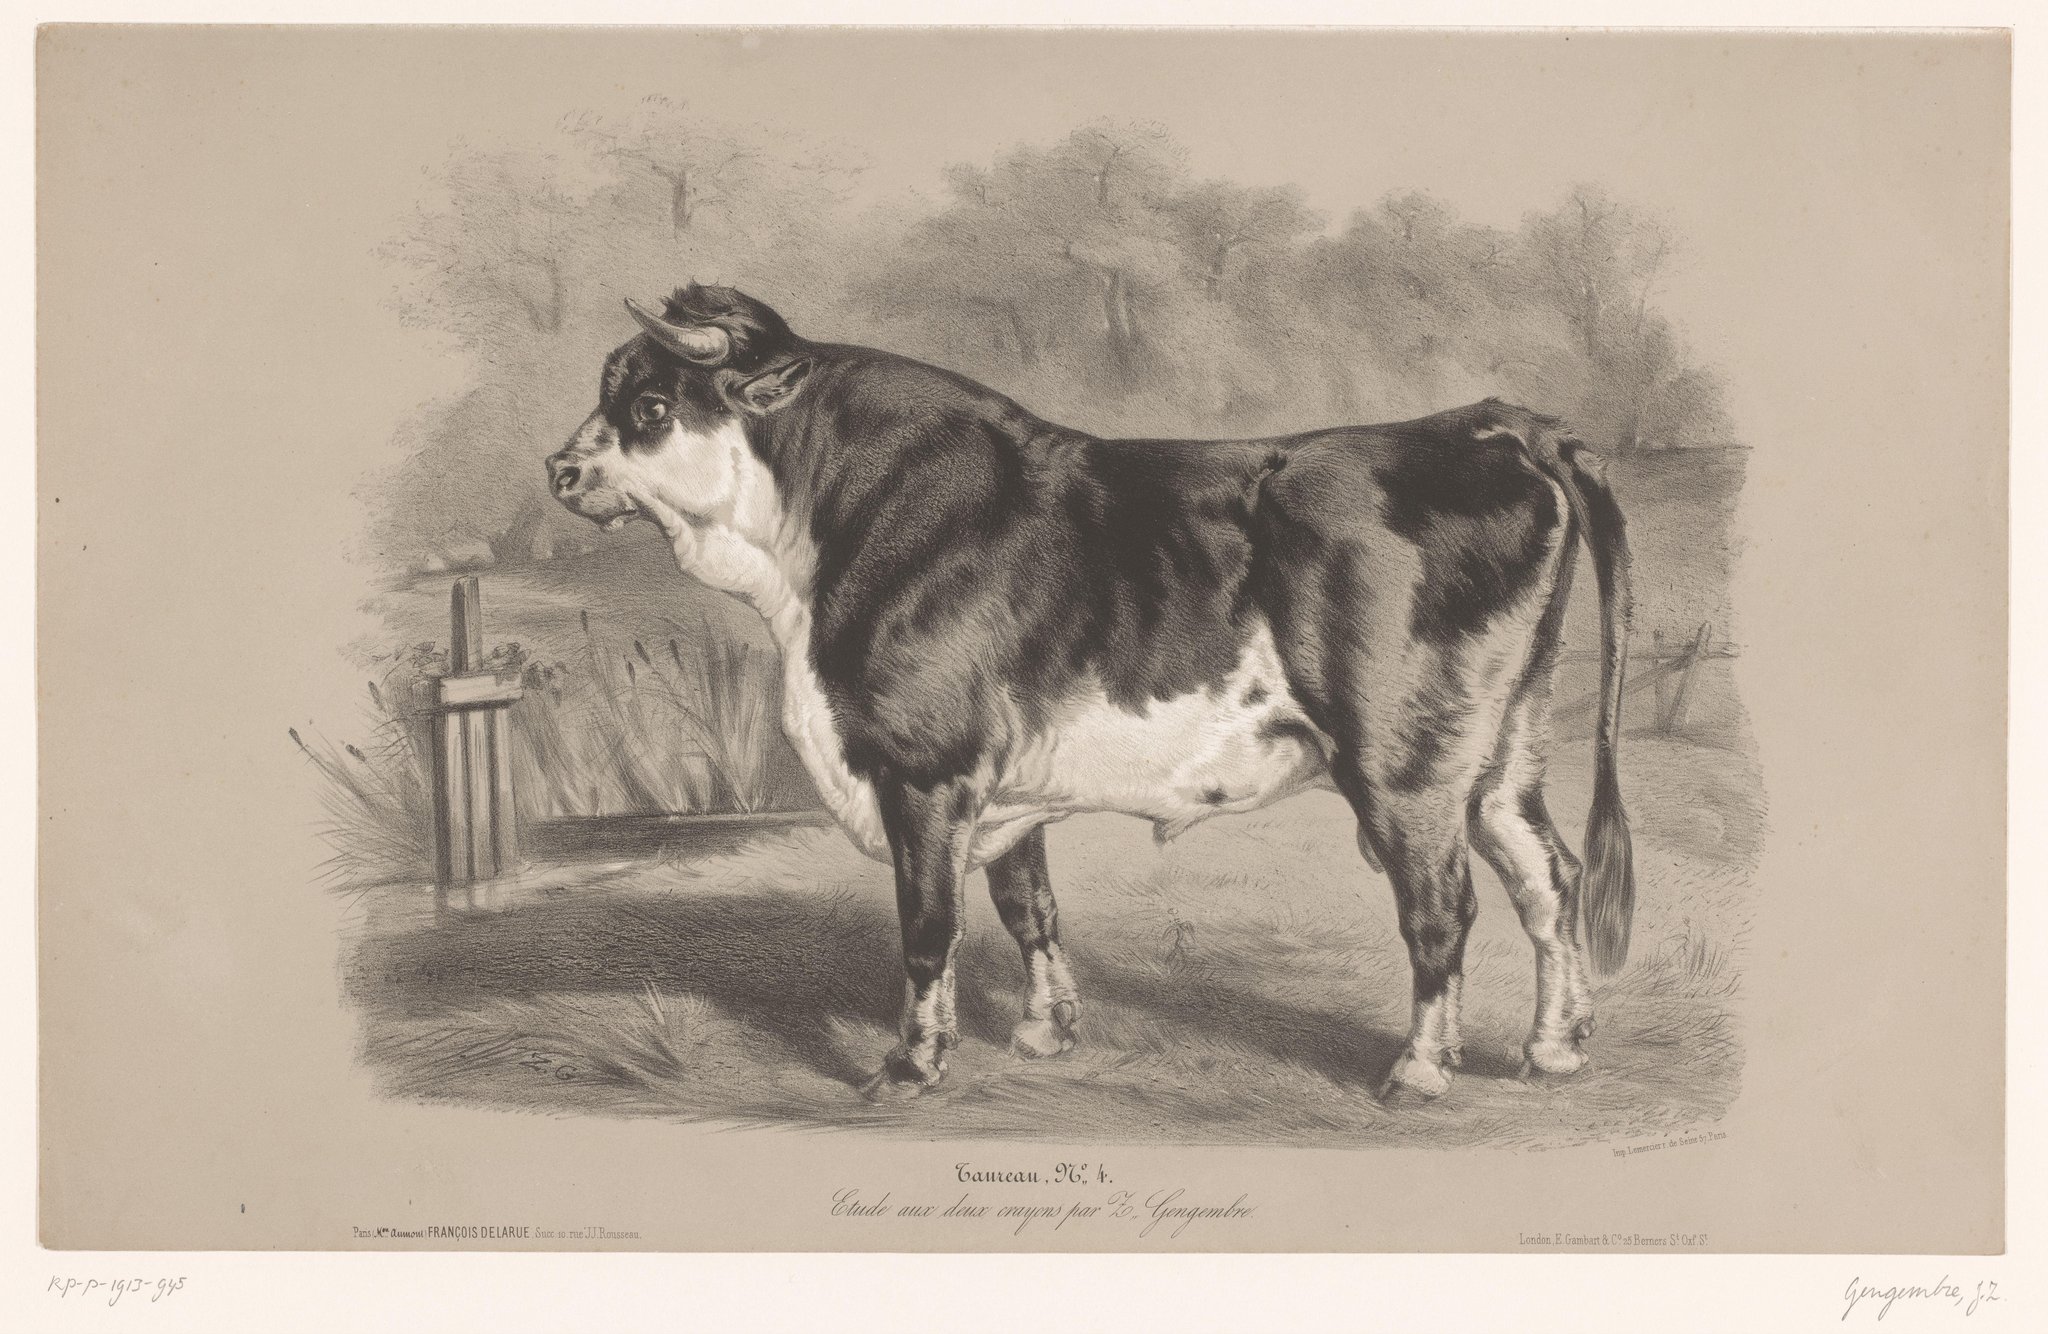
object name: print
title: Stier in een weiland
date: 1850-1870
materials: paper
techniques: lithograph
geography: london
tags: bull, meadow, pasture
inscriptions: collector's mark: Lugt 2228a